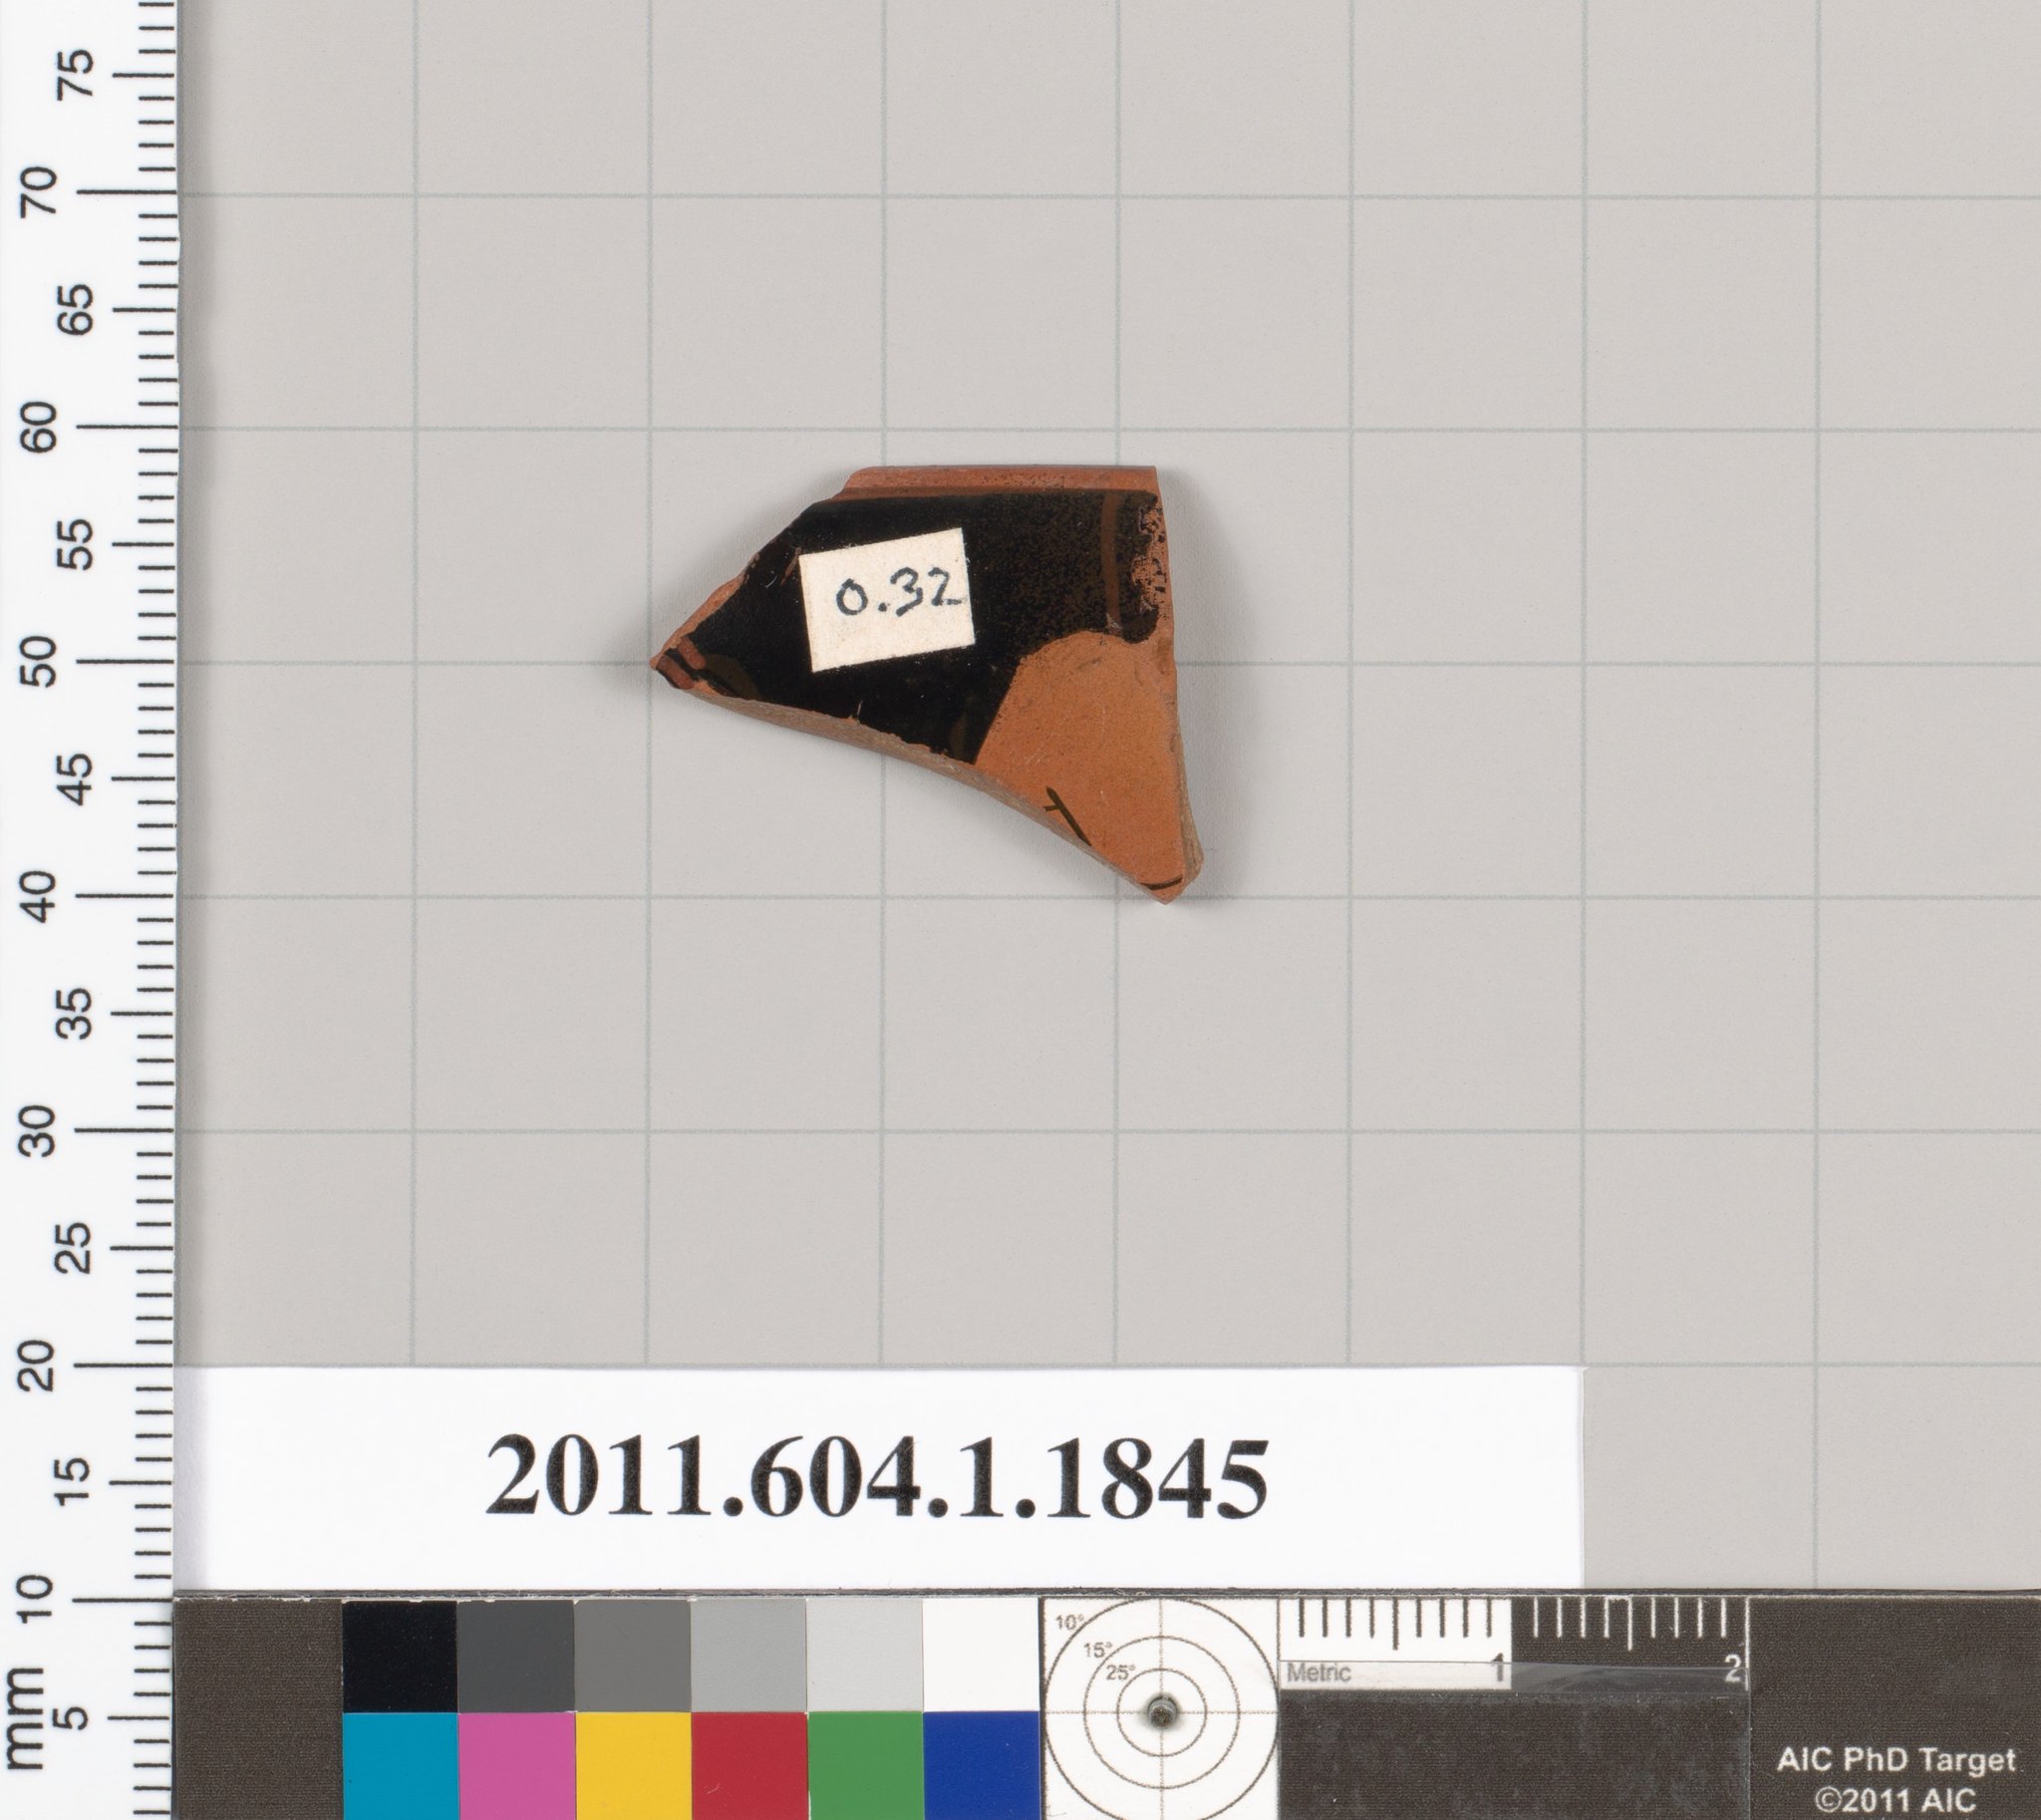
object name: kylix fragment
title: Terracotta rim fragment of a kylix (drinking cup)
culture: greek, attic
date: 467-435 BCE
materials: terracotta